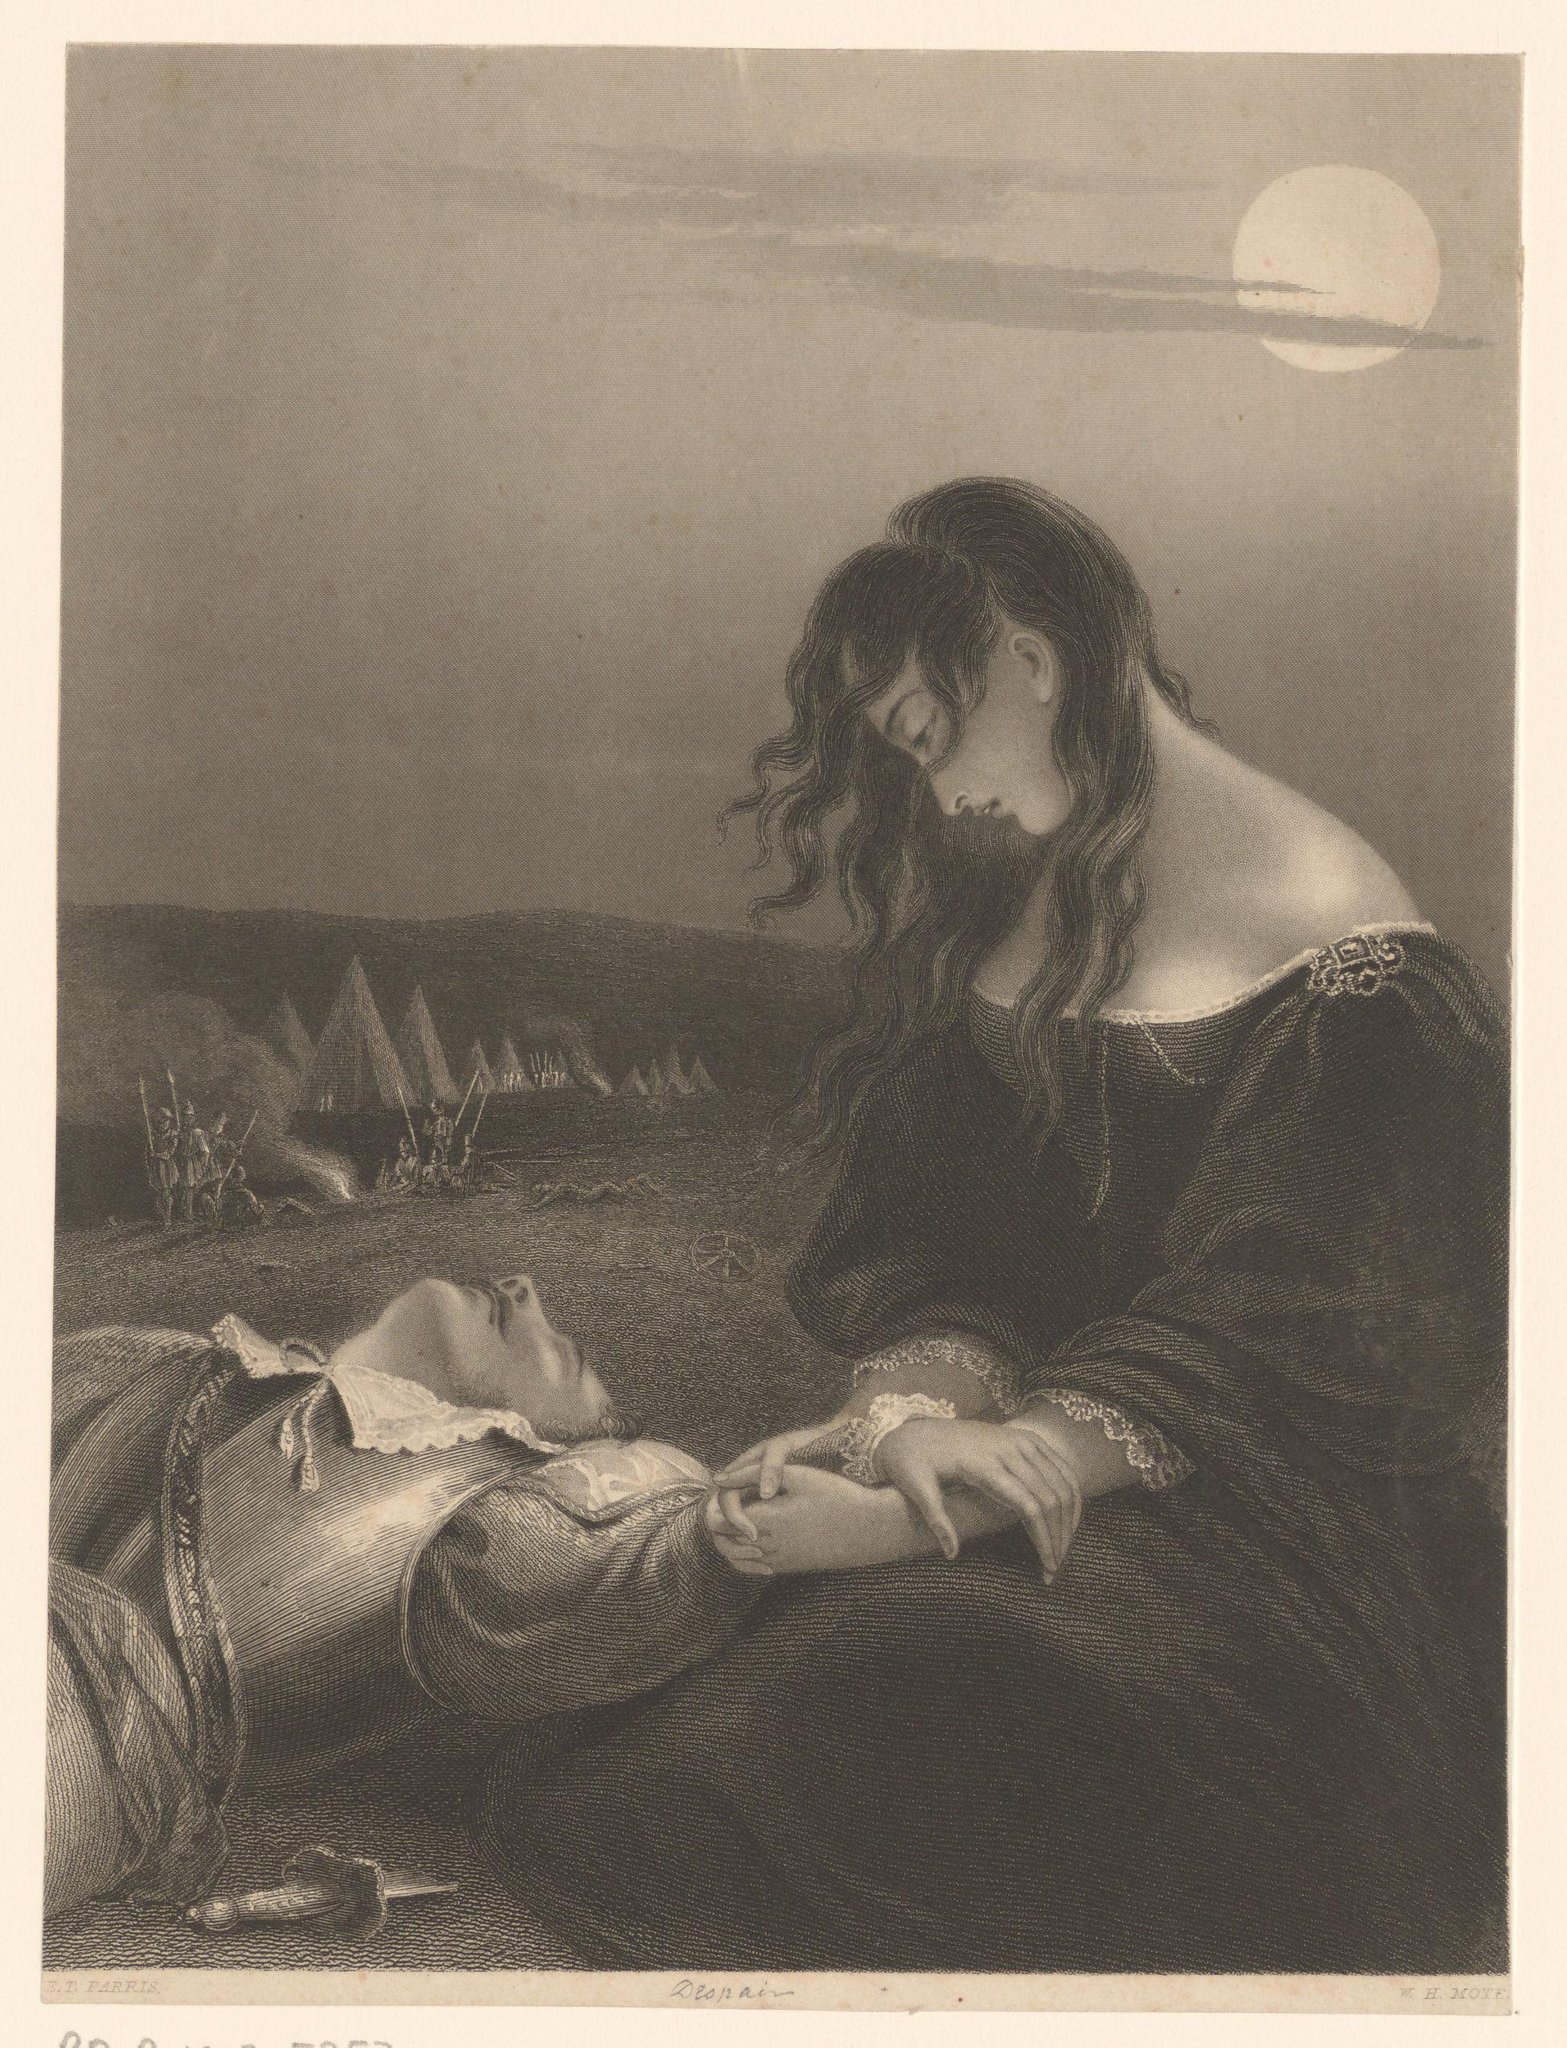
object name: print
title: Despair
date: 1836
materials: paper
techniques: etching, engraving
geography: london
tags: (military) camp with tents, moonlight, the corpse, mourning the dead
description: Prent uit: Gems of Beauty (...). Londen: Longman, Rees, Orme, Brown, Green, and Longman, 1836.